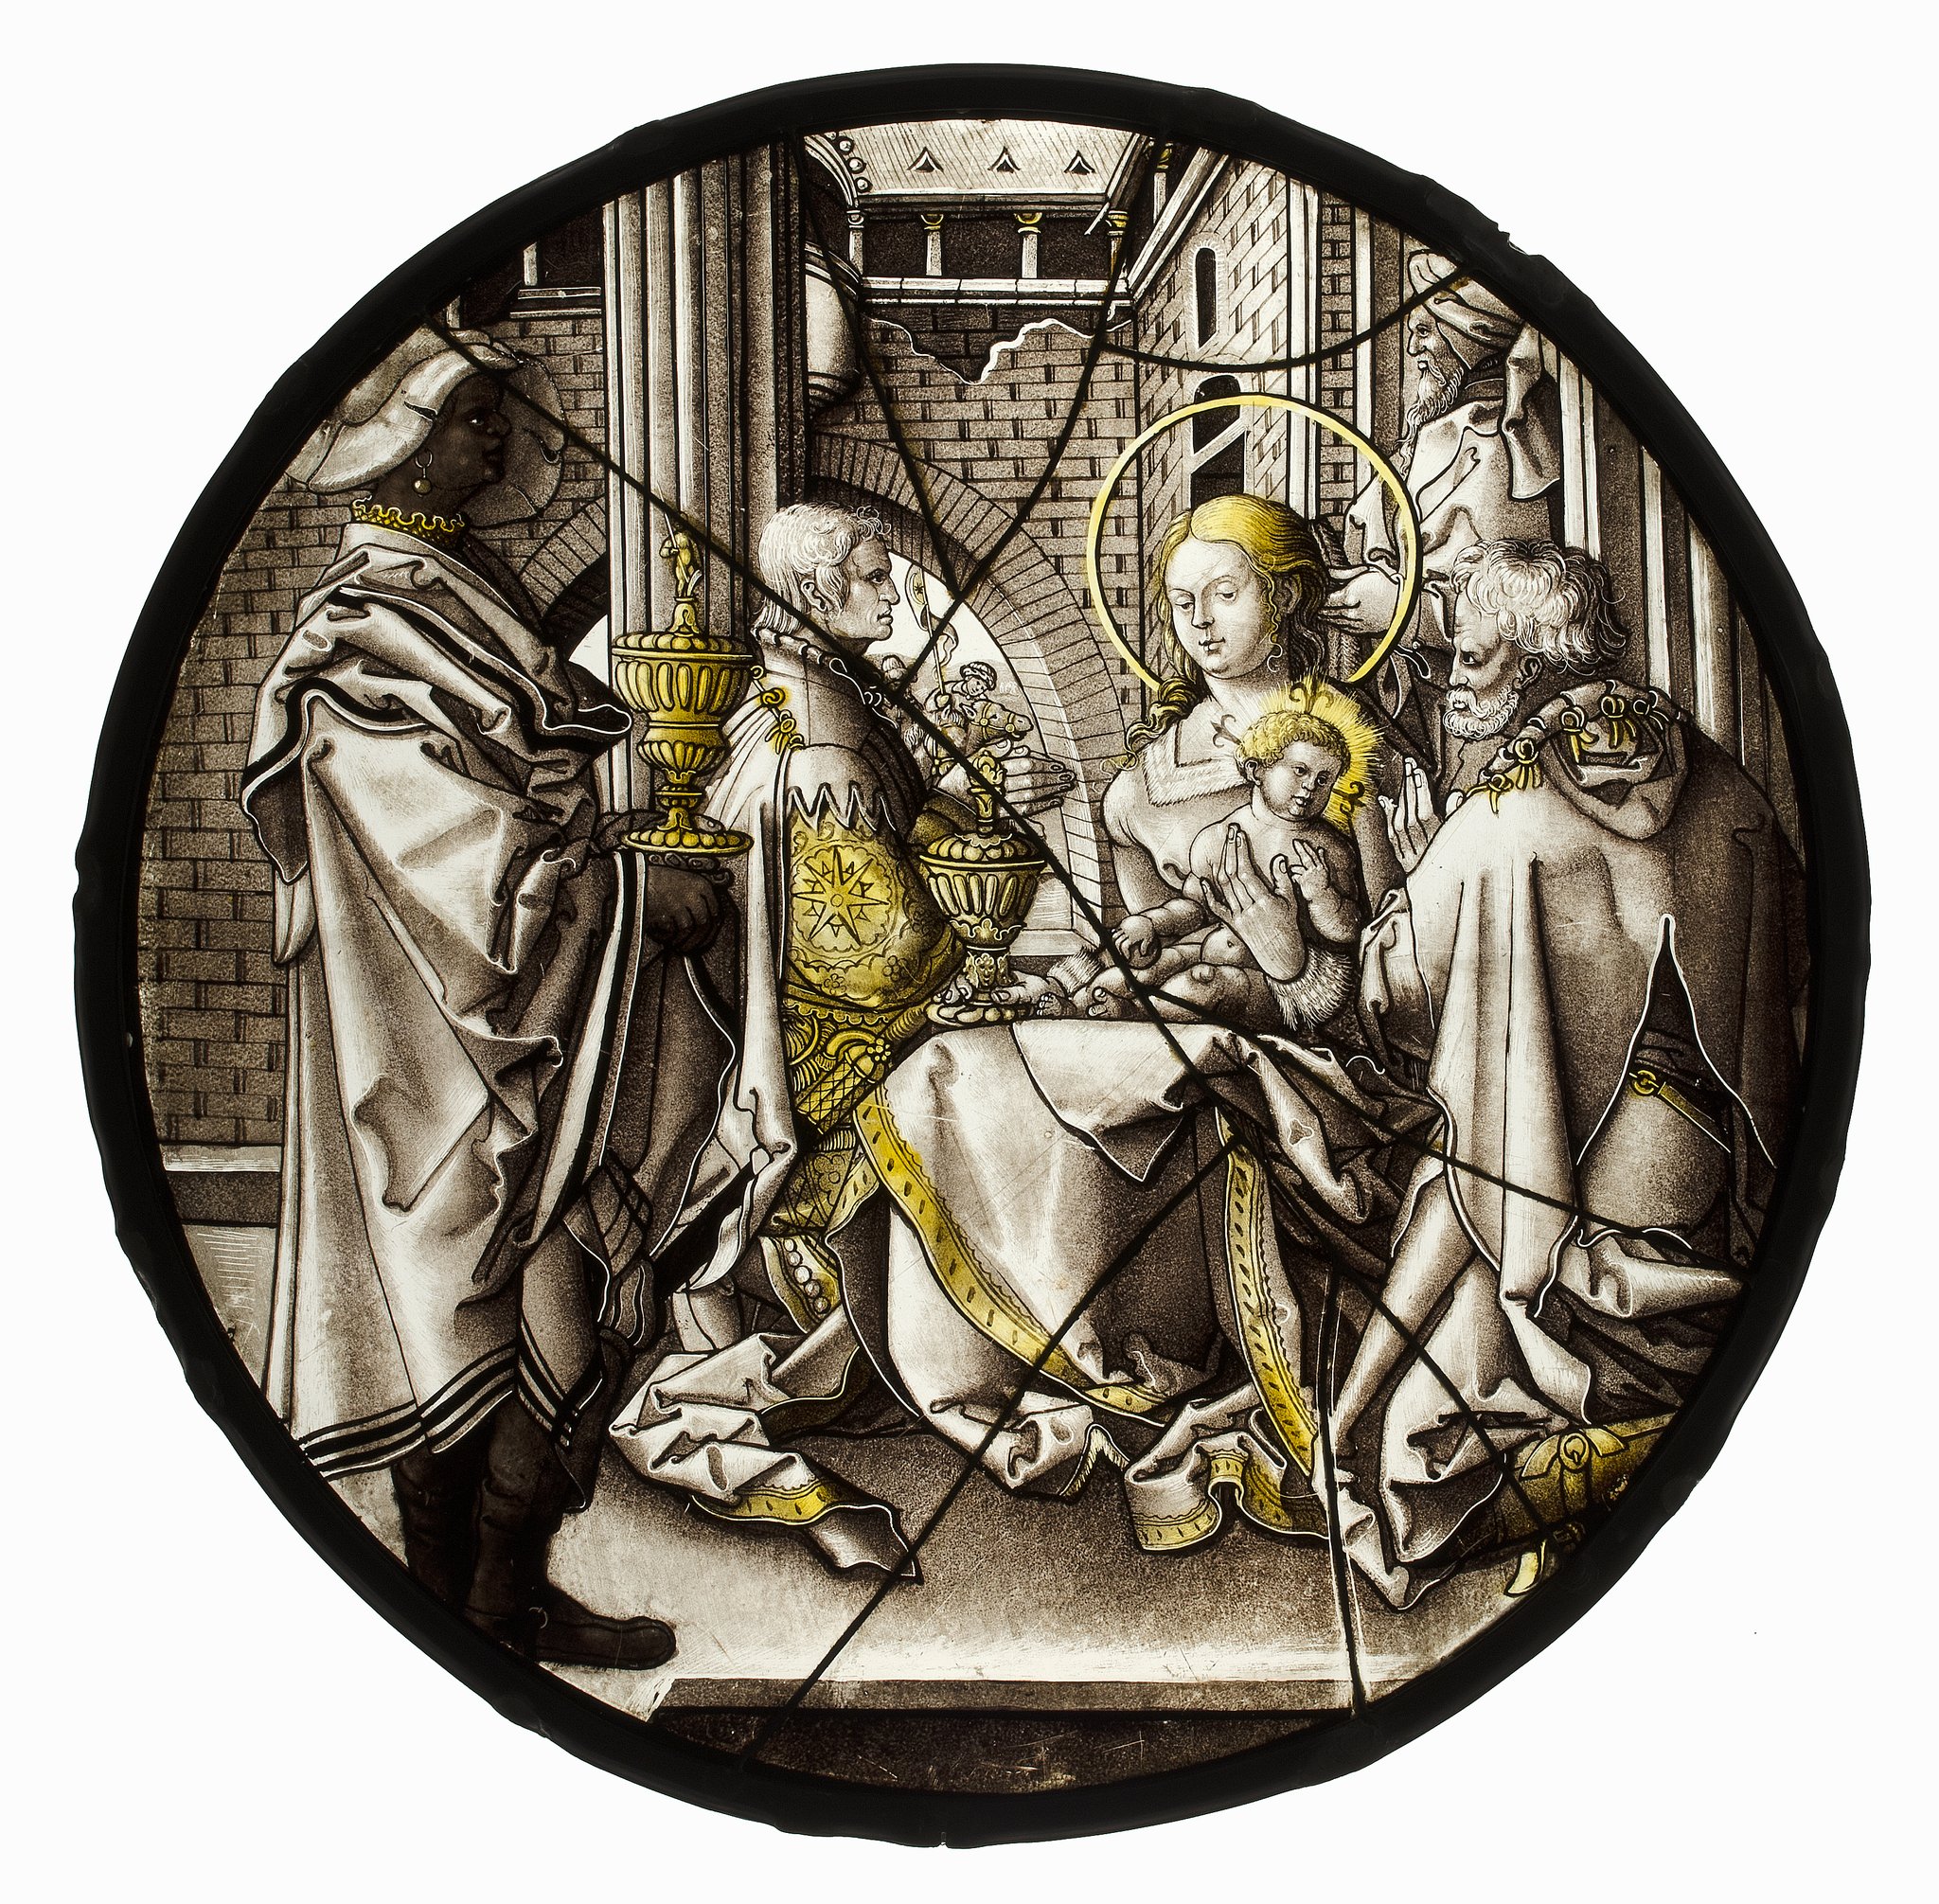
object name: roundel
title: Roundel with Adoration of the Magi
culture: german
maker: heinrich aldegrever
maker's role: artist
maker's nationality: german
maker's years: 1502-1561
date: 1535-1545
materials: glass, paint, pigment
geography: germany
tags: virgin mary,jesus,adoration of the magi